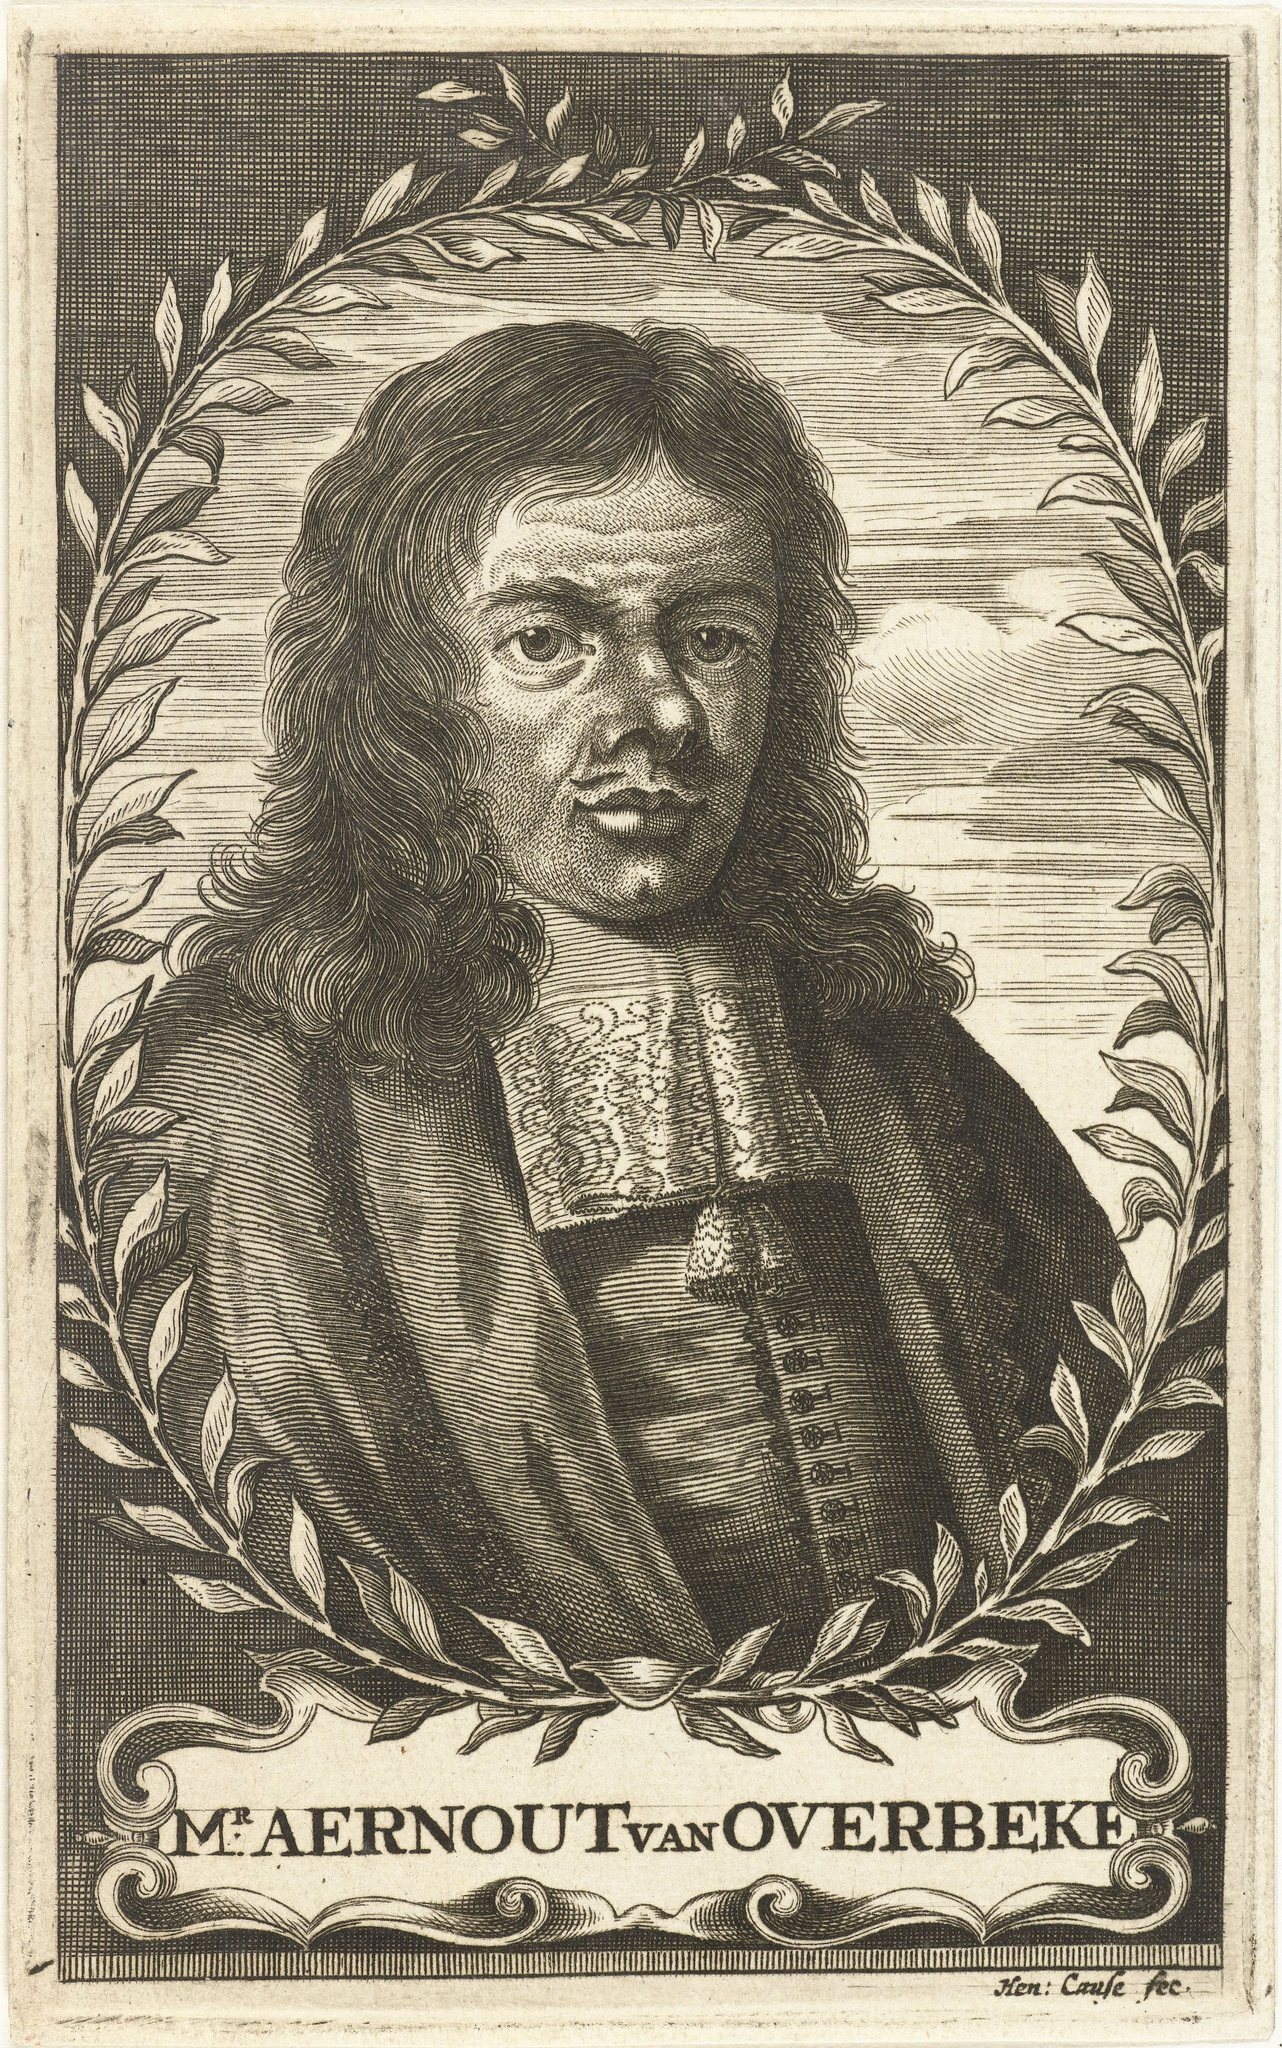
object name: print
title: Portret van Aernout van Overbeke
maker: hendrik causé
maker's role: print maker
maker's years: 1648-1699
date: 1663-1699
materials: paper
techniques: engraving, etching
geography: antwerp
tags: advocaat, admiraal, aernout van overbeke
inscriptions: collector's mark: Lugt 2228